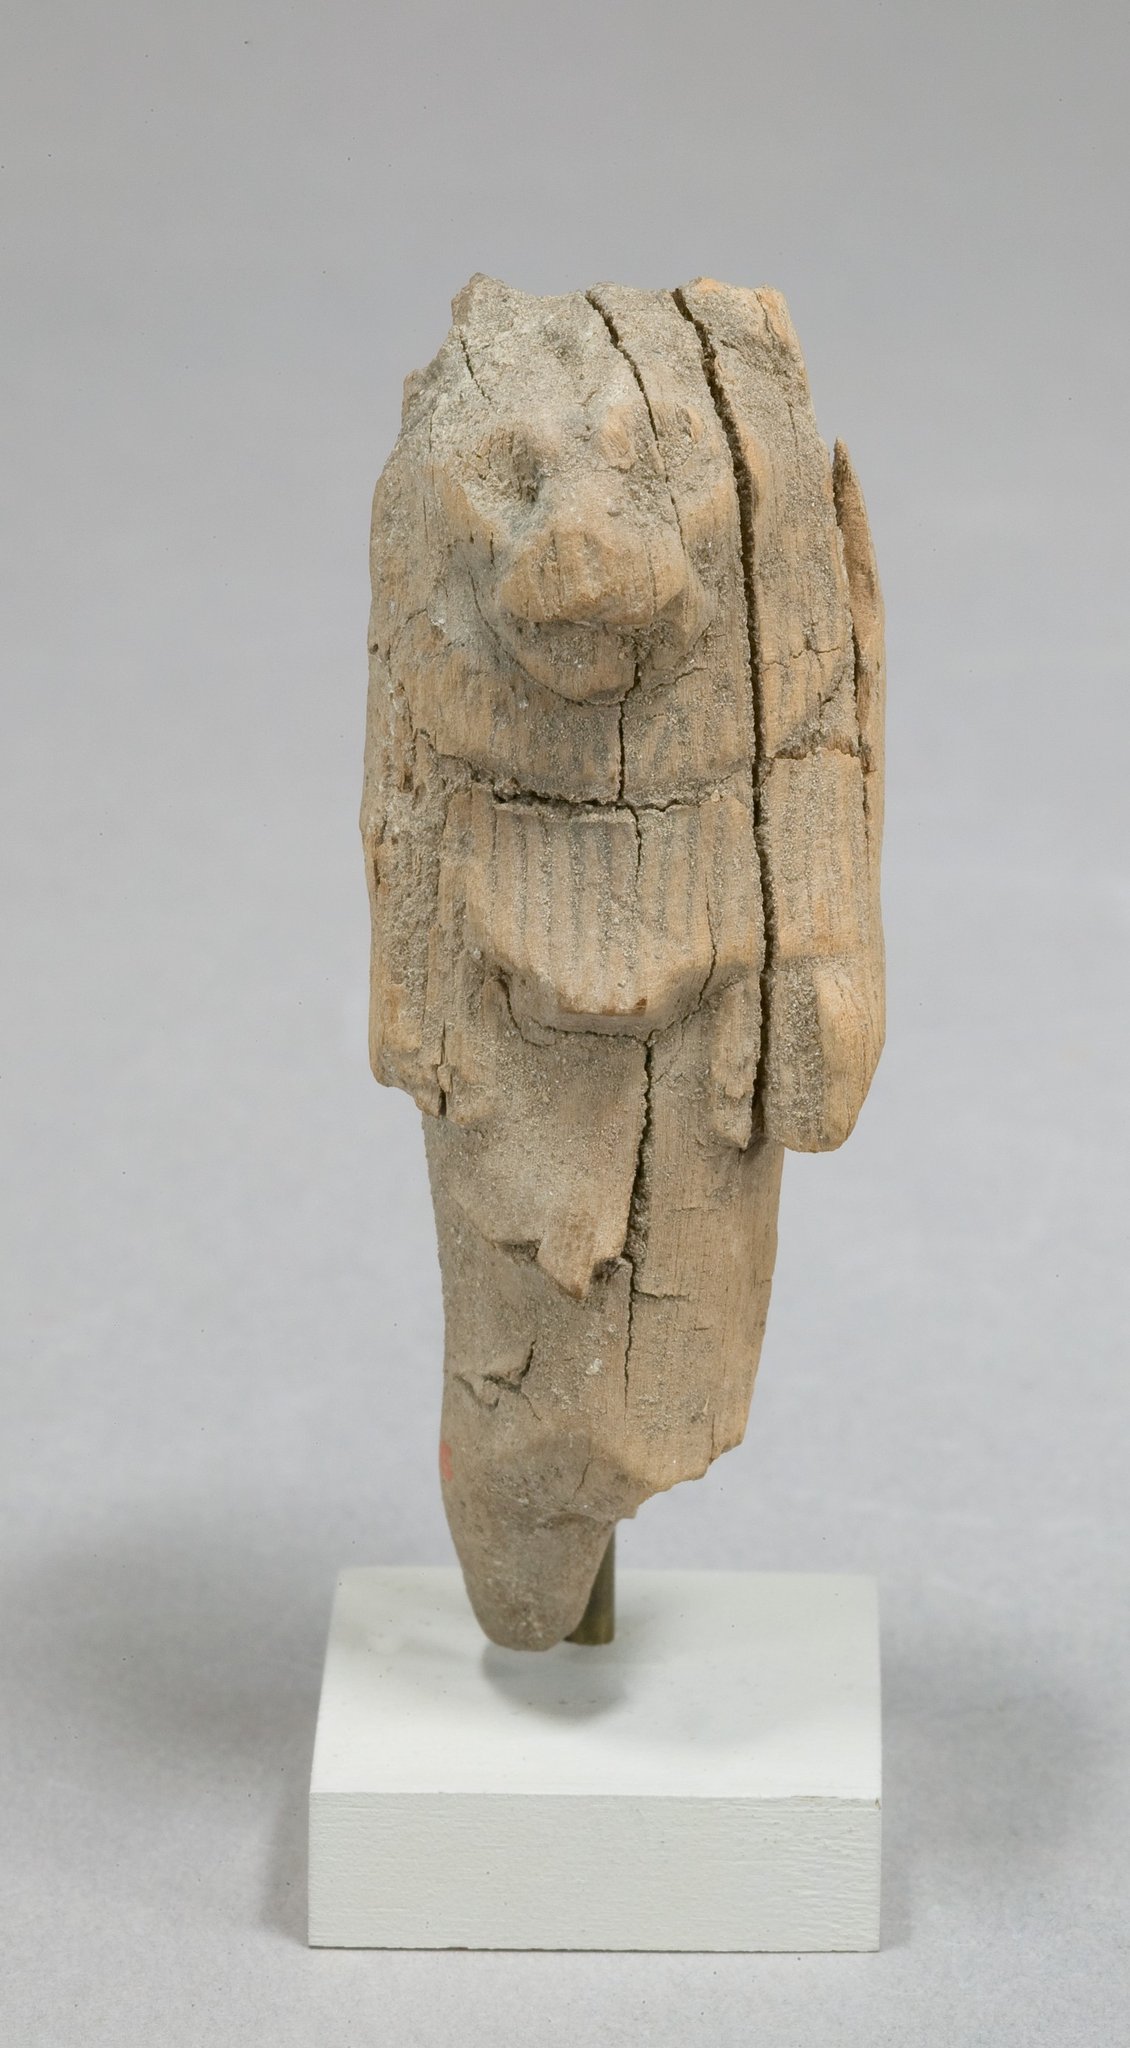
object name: figurine, lion upright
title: Lion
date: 1700-1550 BCE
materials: wood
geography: egypt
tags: lions